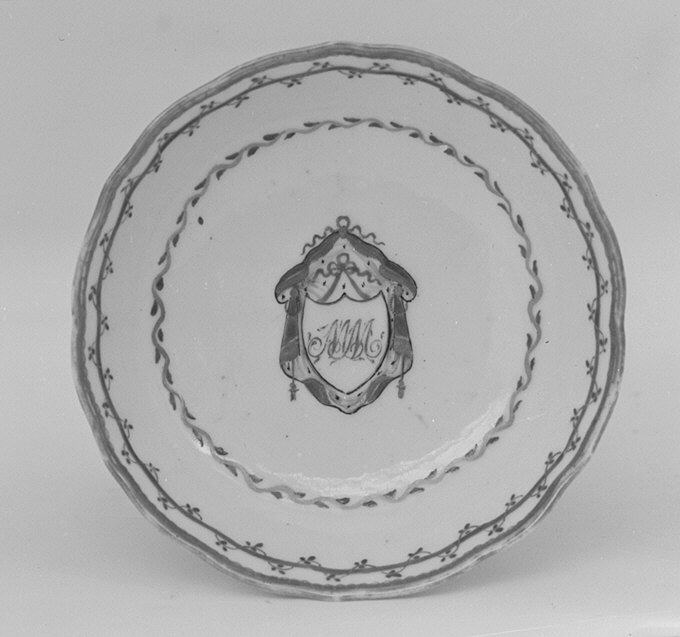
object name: saucer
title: Saucer (part of a miniature service)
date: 1790-1800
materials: hard paste porcelain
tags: coat of arms